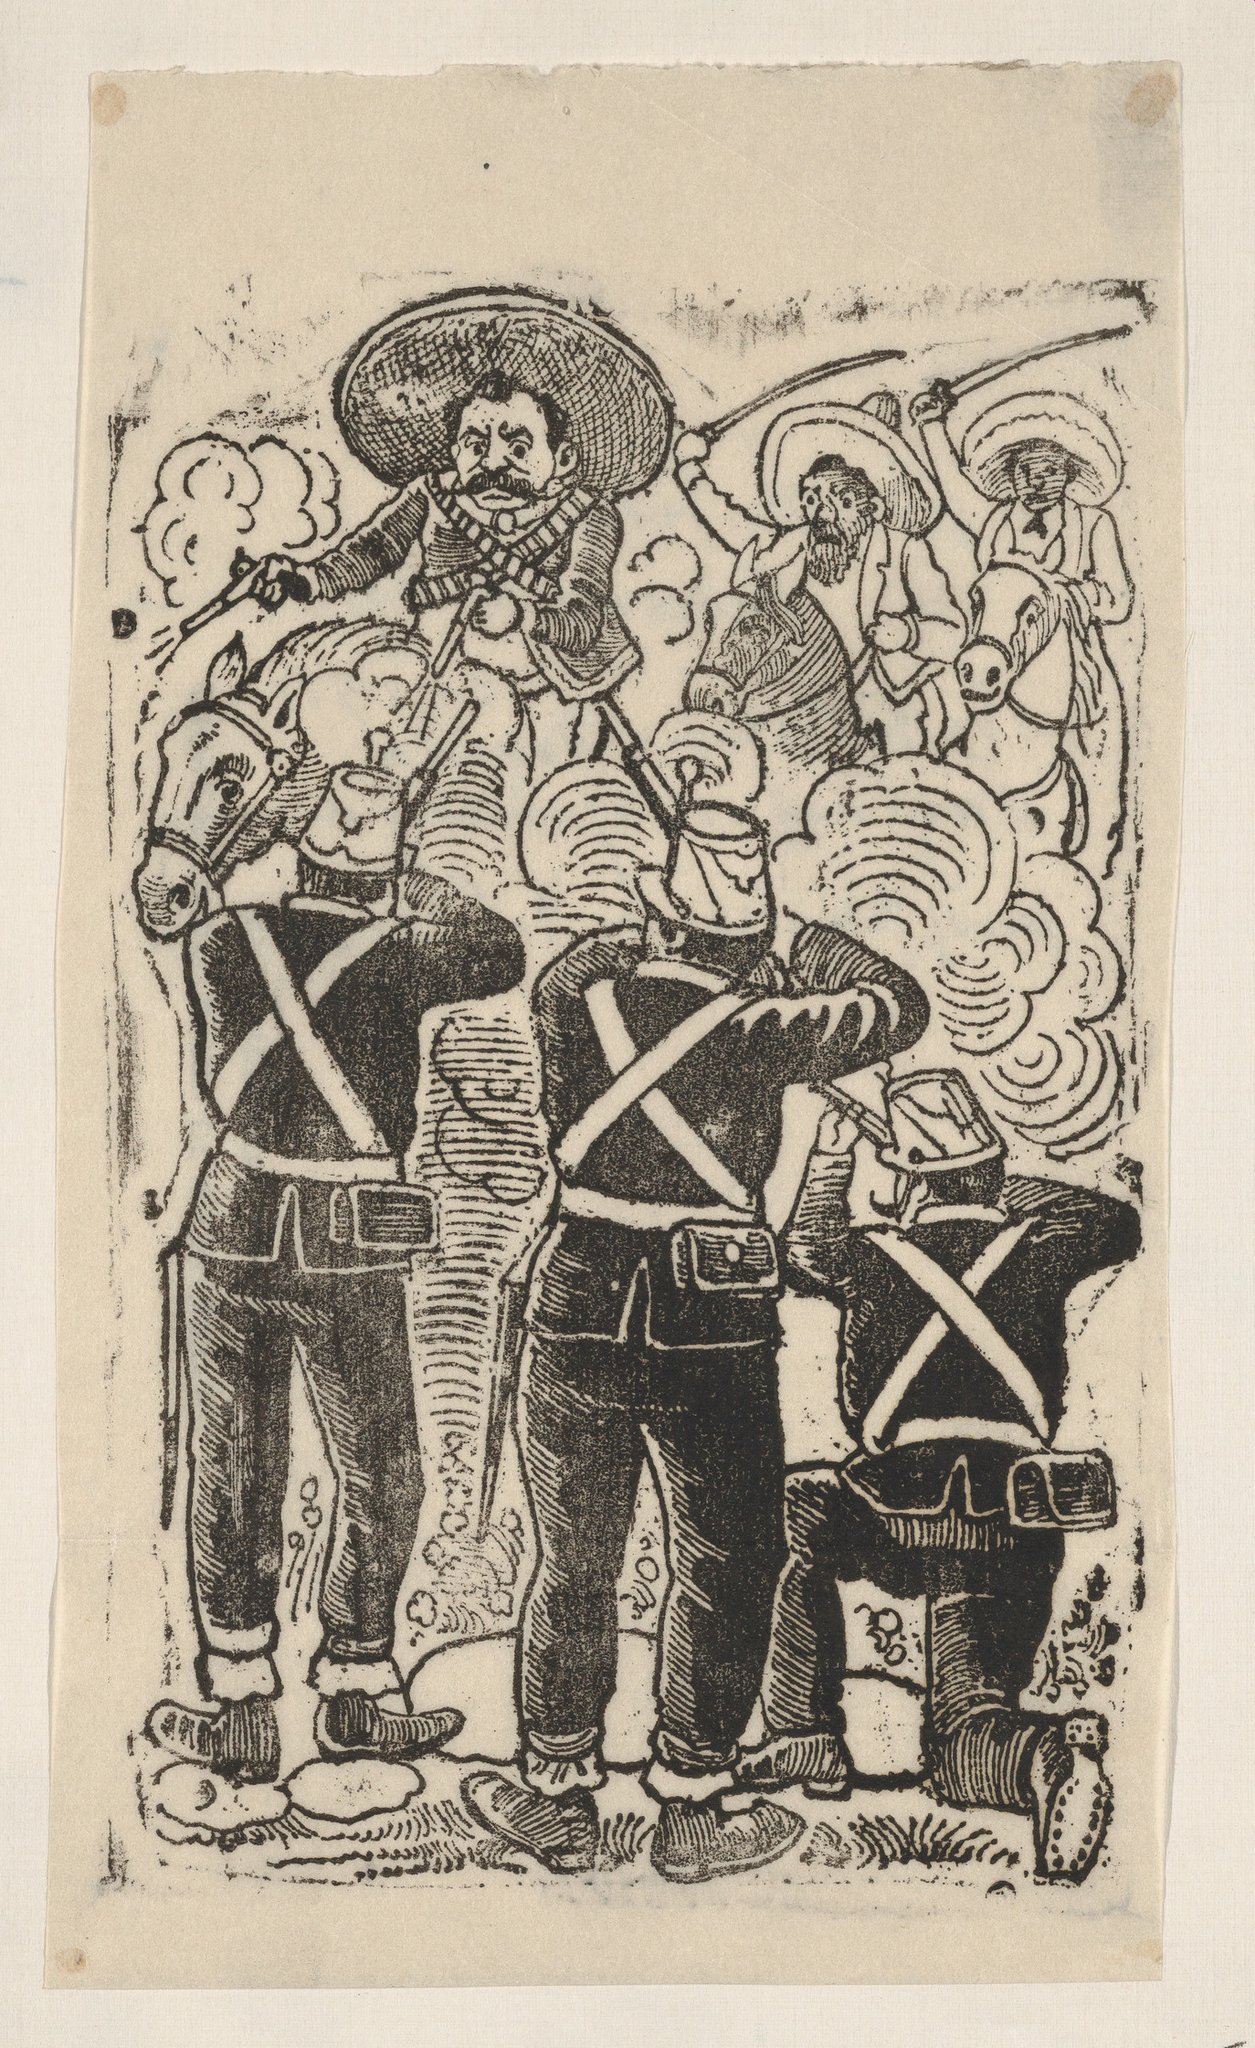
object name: print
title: A gun fight between those supporting agrarian reform led by Zapata and the military opposition during the Mexican revolution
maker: josé guadalupe posada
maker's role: artist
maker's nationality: mexican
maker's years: 1852-1913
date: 1912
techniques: lithography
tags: military,men,horses